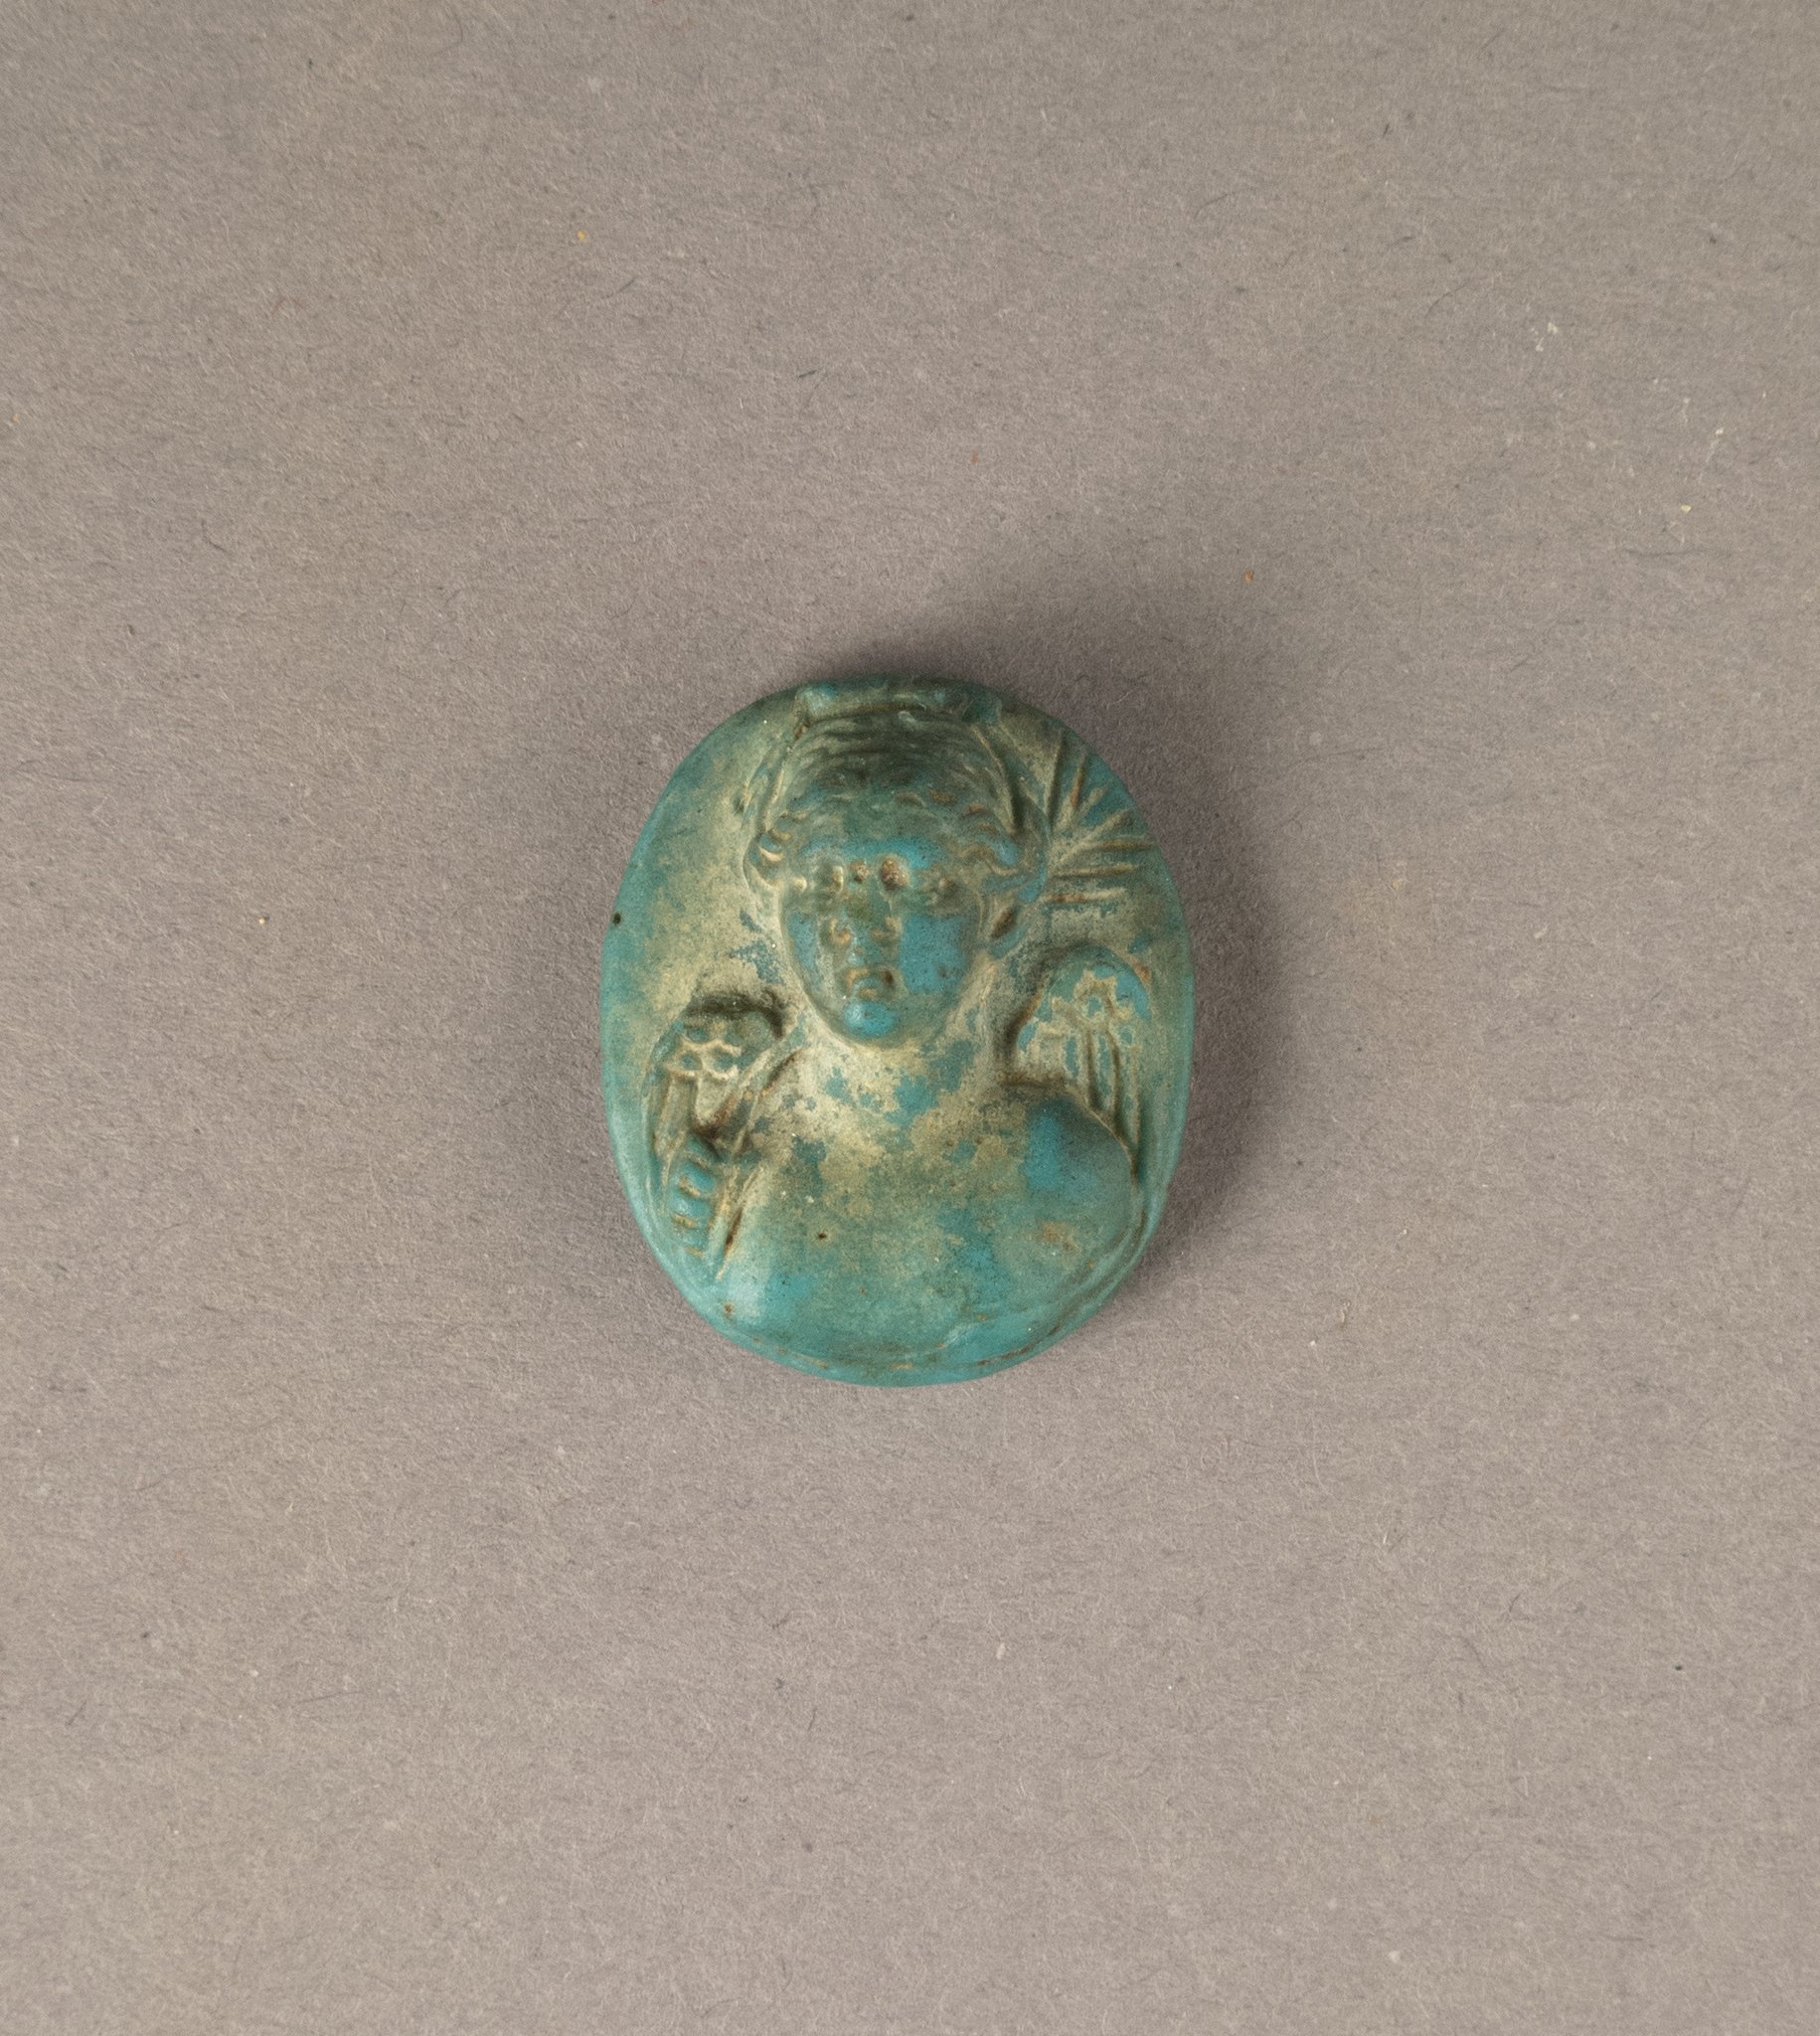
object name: medallion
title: Glass medallion with winged Victory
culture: roman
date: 100 BCE-300 CE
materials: glass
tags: victory